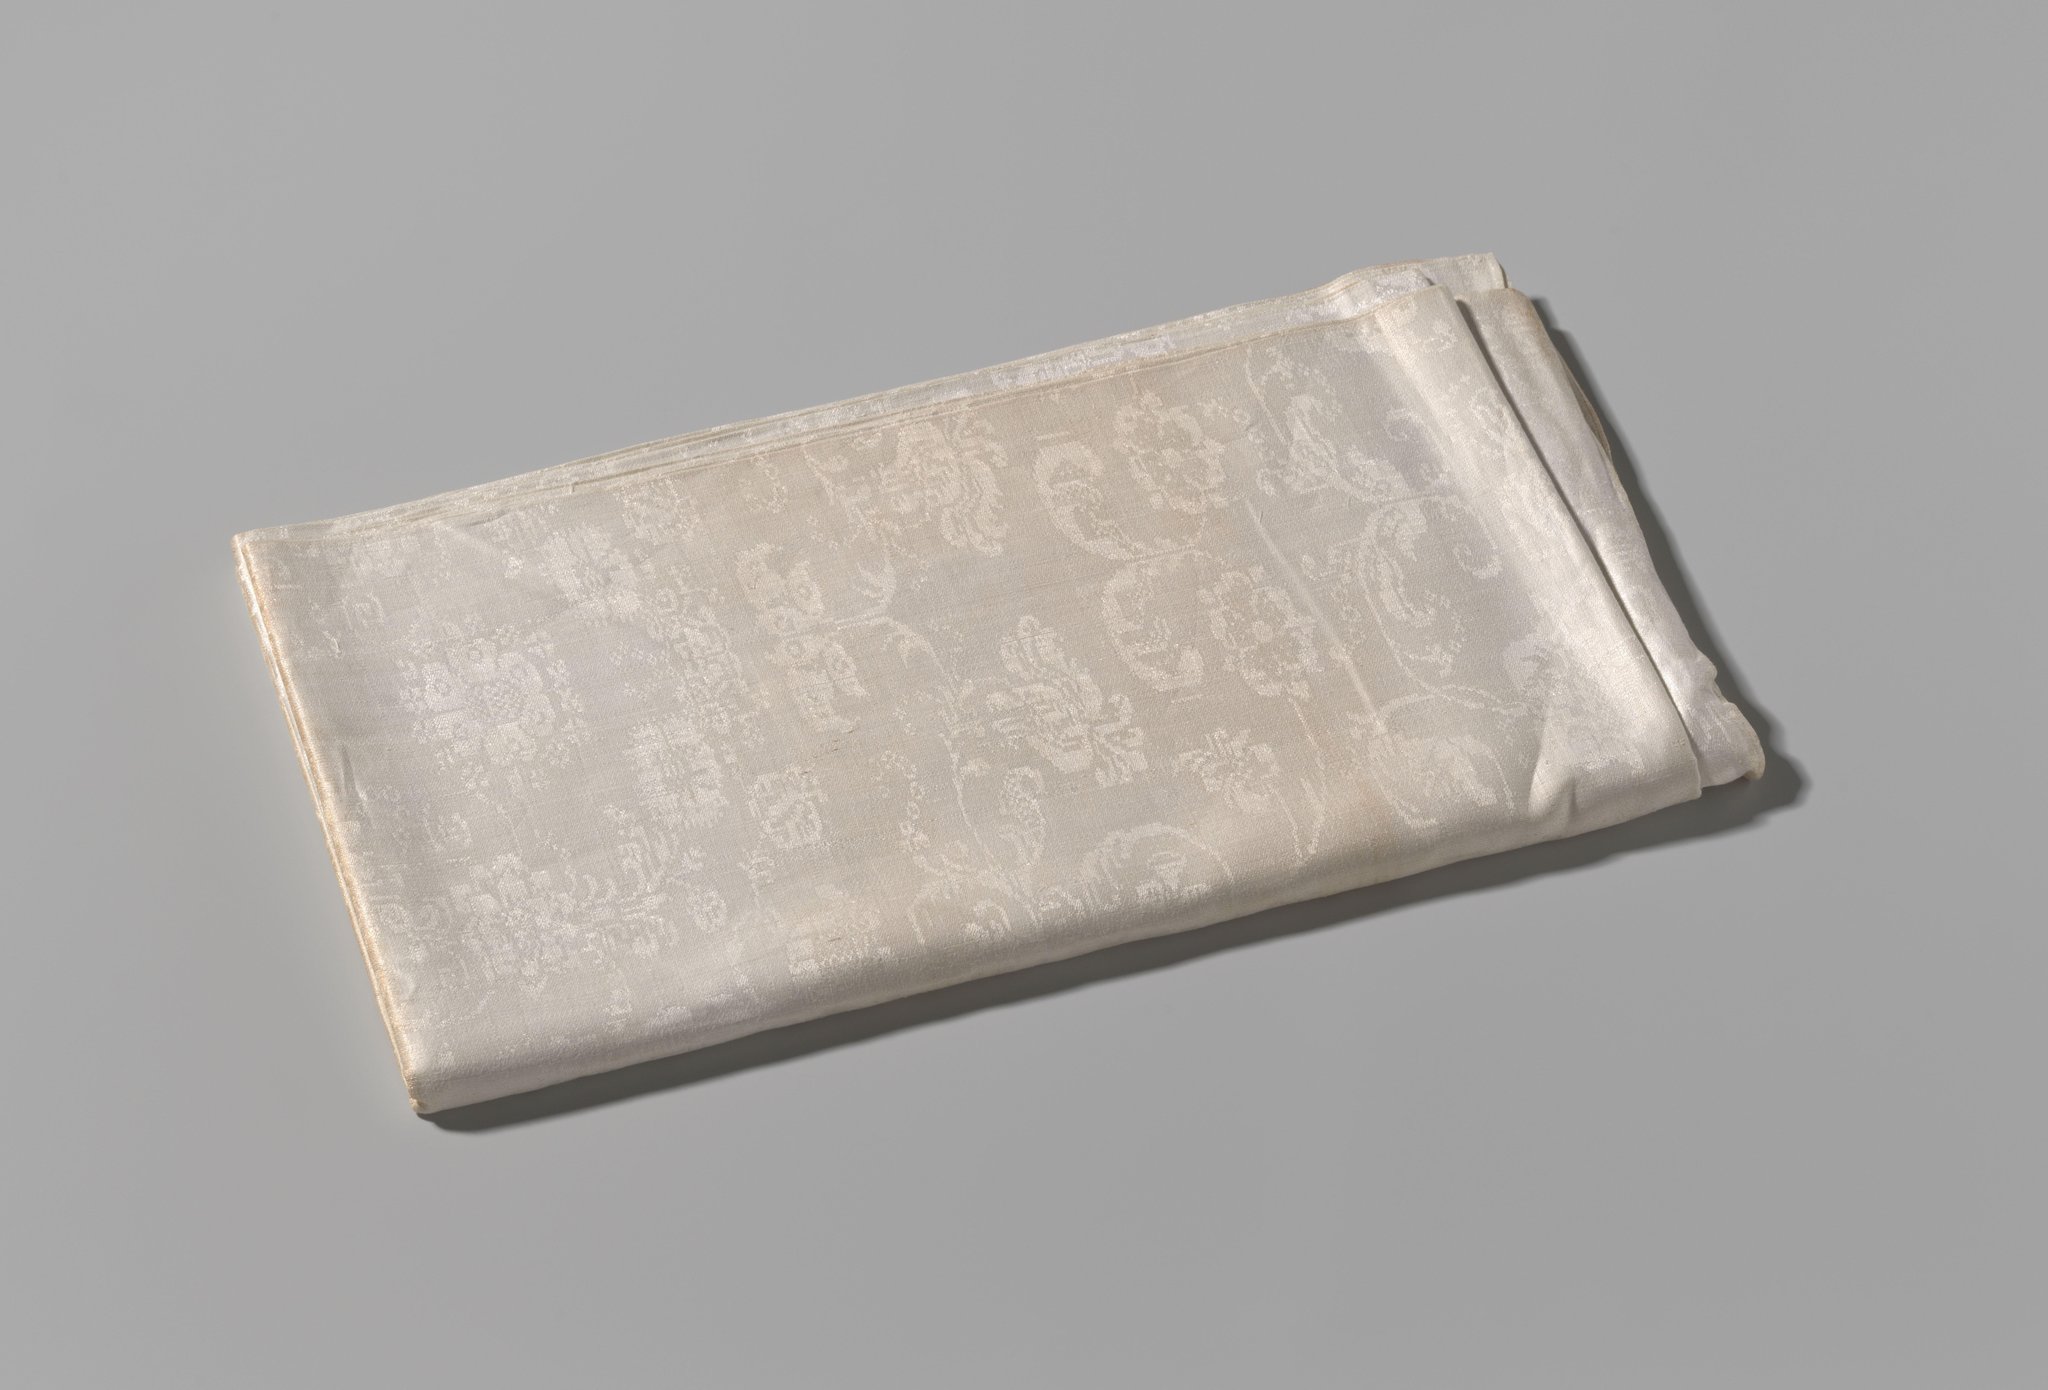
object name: tablecloth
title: Gestrooide bloemen. Merk: TC1.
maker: Anonymous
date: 1690-1710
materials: linen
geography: northern netherlands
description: Tafellaken met patroon van gestrooide bloemen, merk TC 1